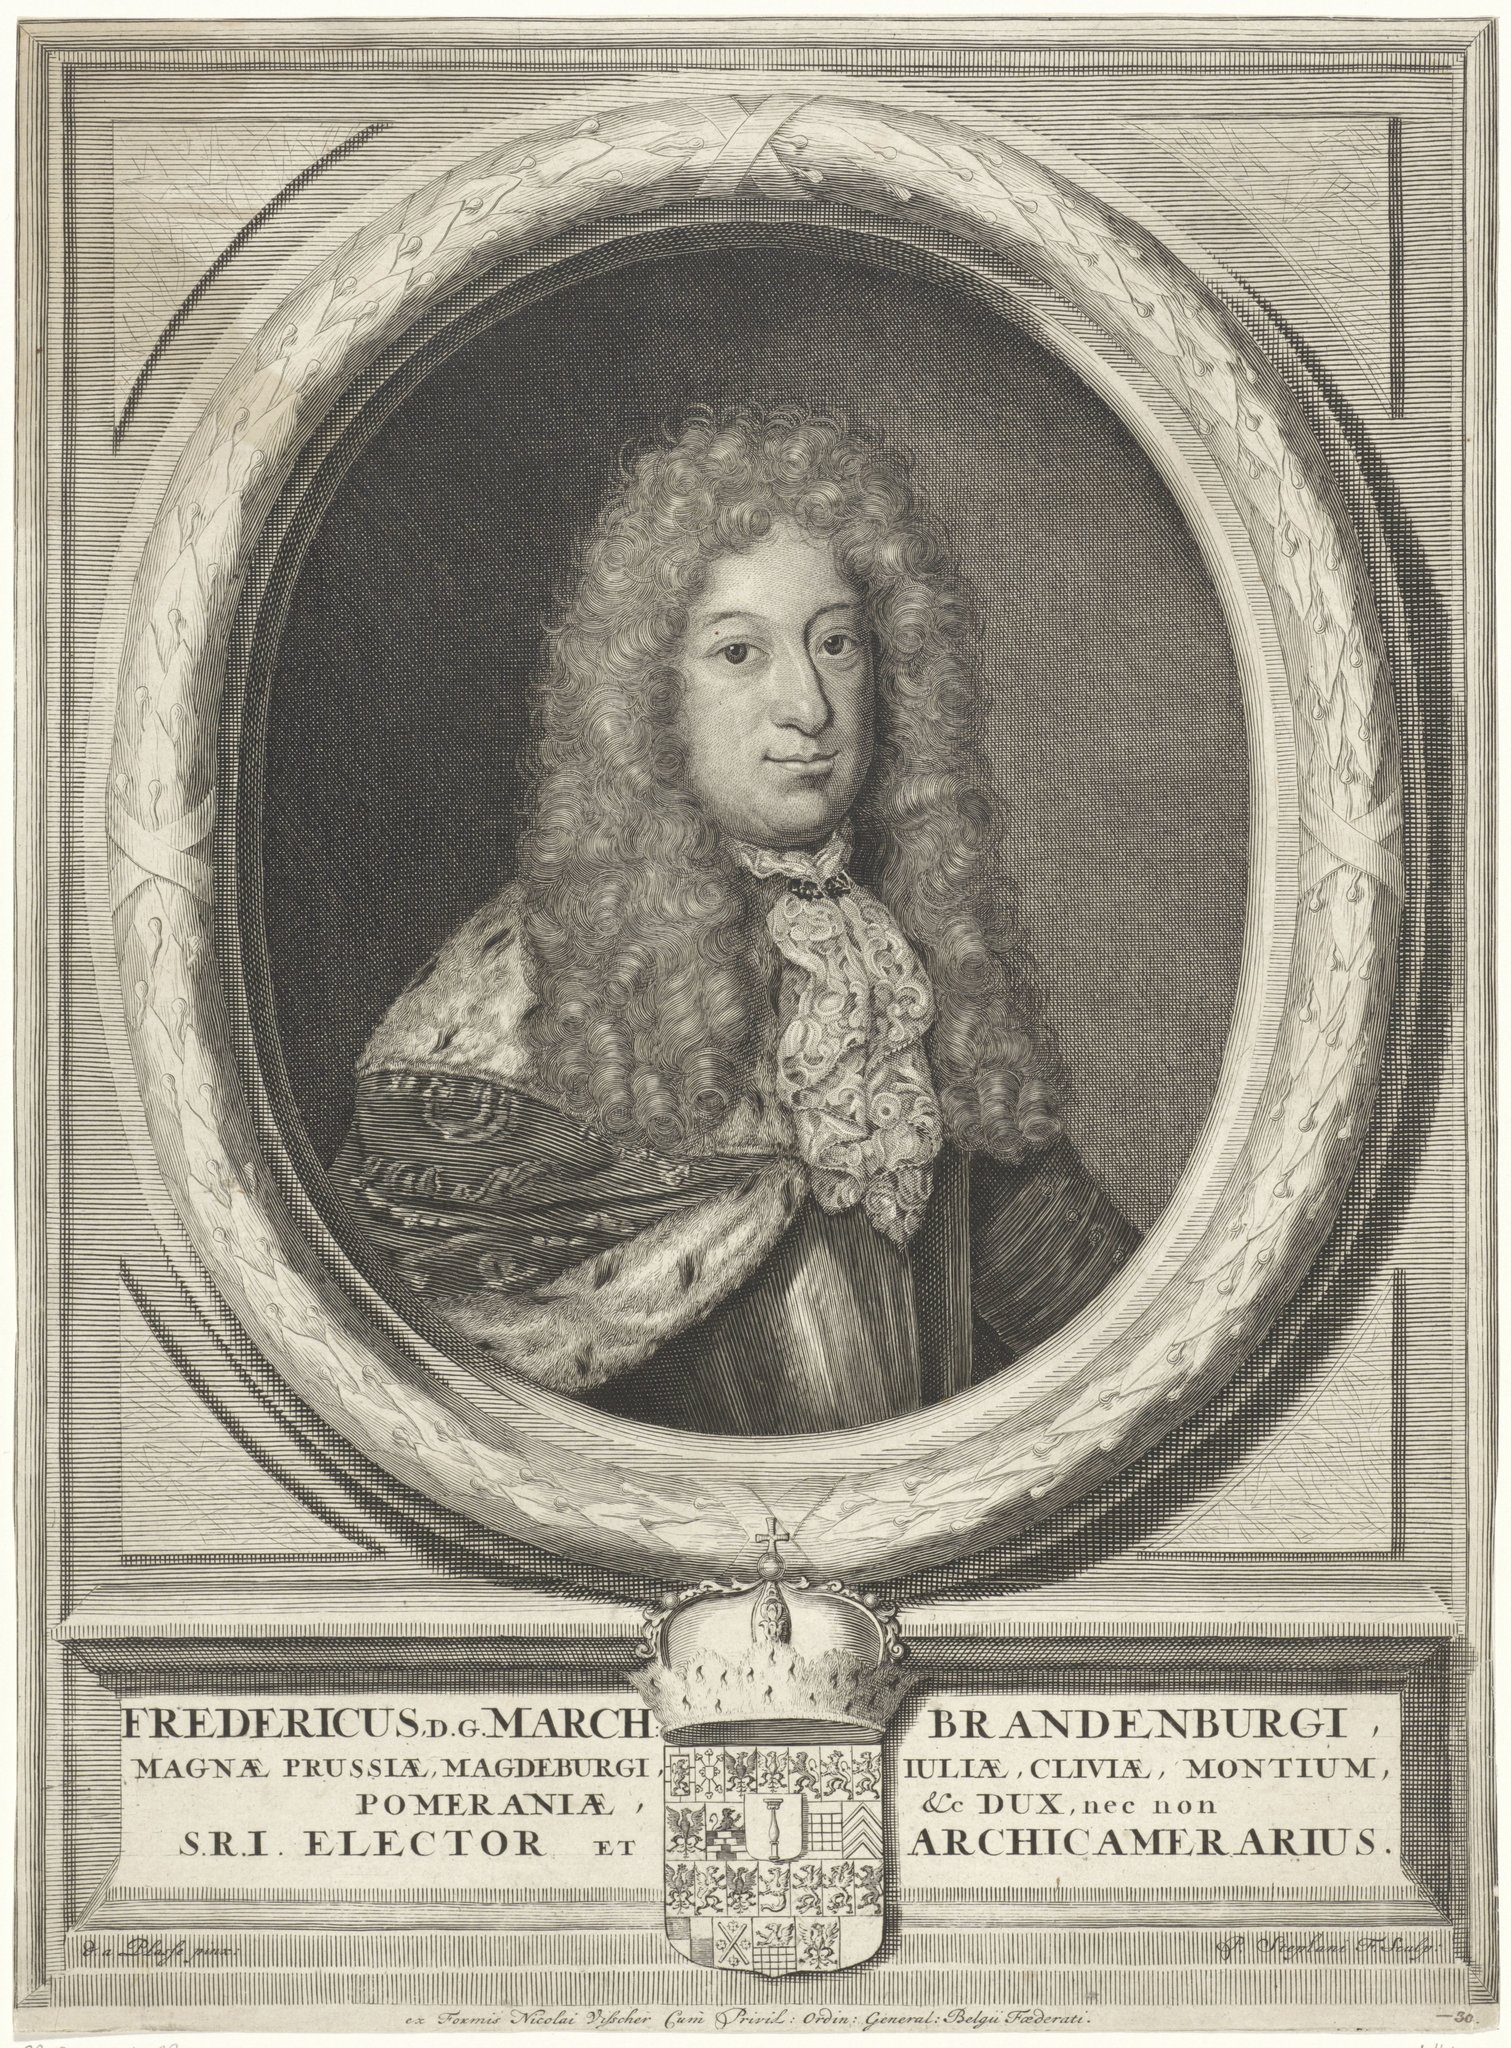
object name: print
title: Portret van keurvorst Frederik III van Brandenburg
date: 1688-1702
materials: paper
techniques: engraving, etching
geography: amsterdam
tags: berlin, frederik i koning van pruisen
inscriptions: collector's mark: Lugt 2228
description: Portret van Frederik III (Frederik I, koning van Pruisen) als keurvorst van Brandenburg, in een ovale lijst. Midden onder zijn gekroonde wapenschild.